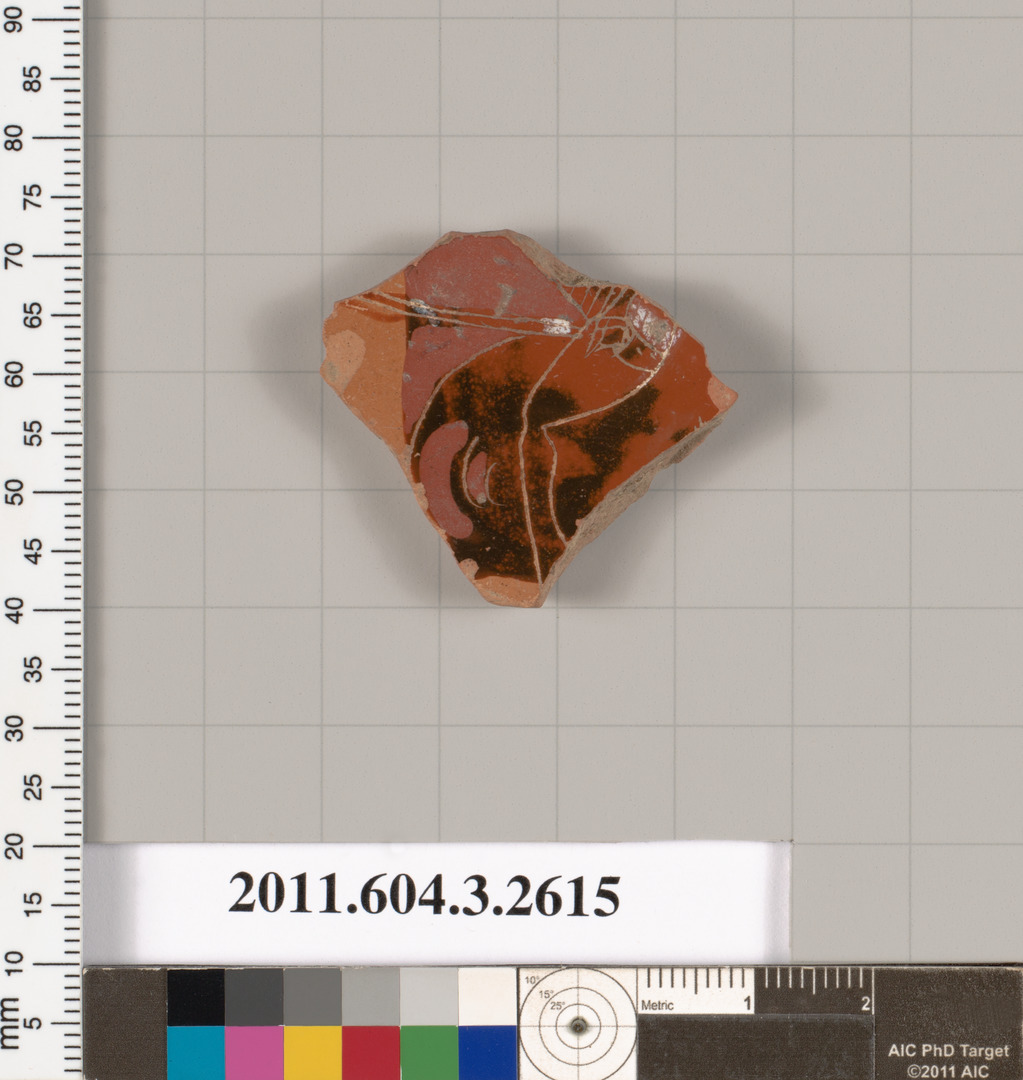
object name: kylix fragment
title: Terracotta fragment of a kylix (drinking cup)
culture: greek, attic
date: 550-526 BCE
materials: terracotta